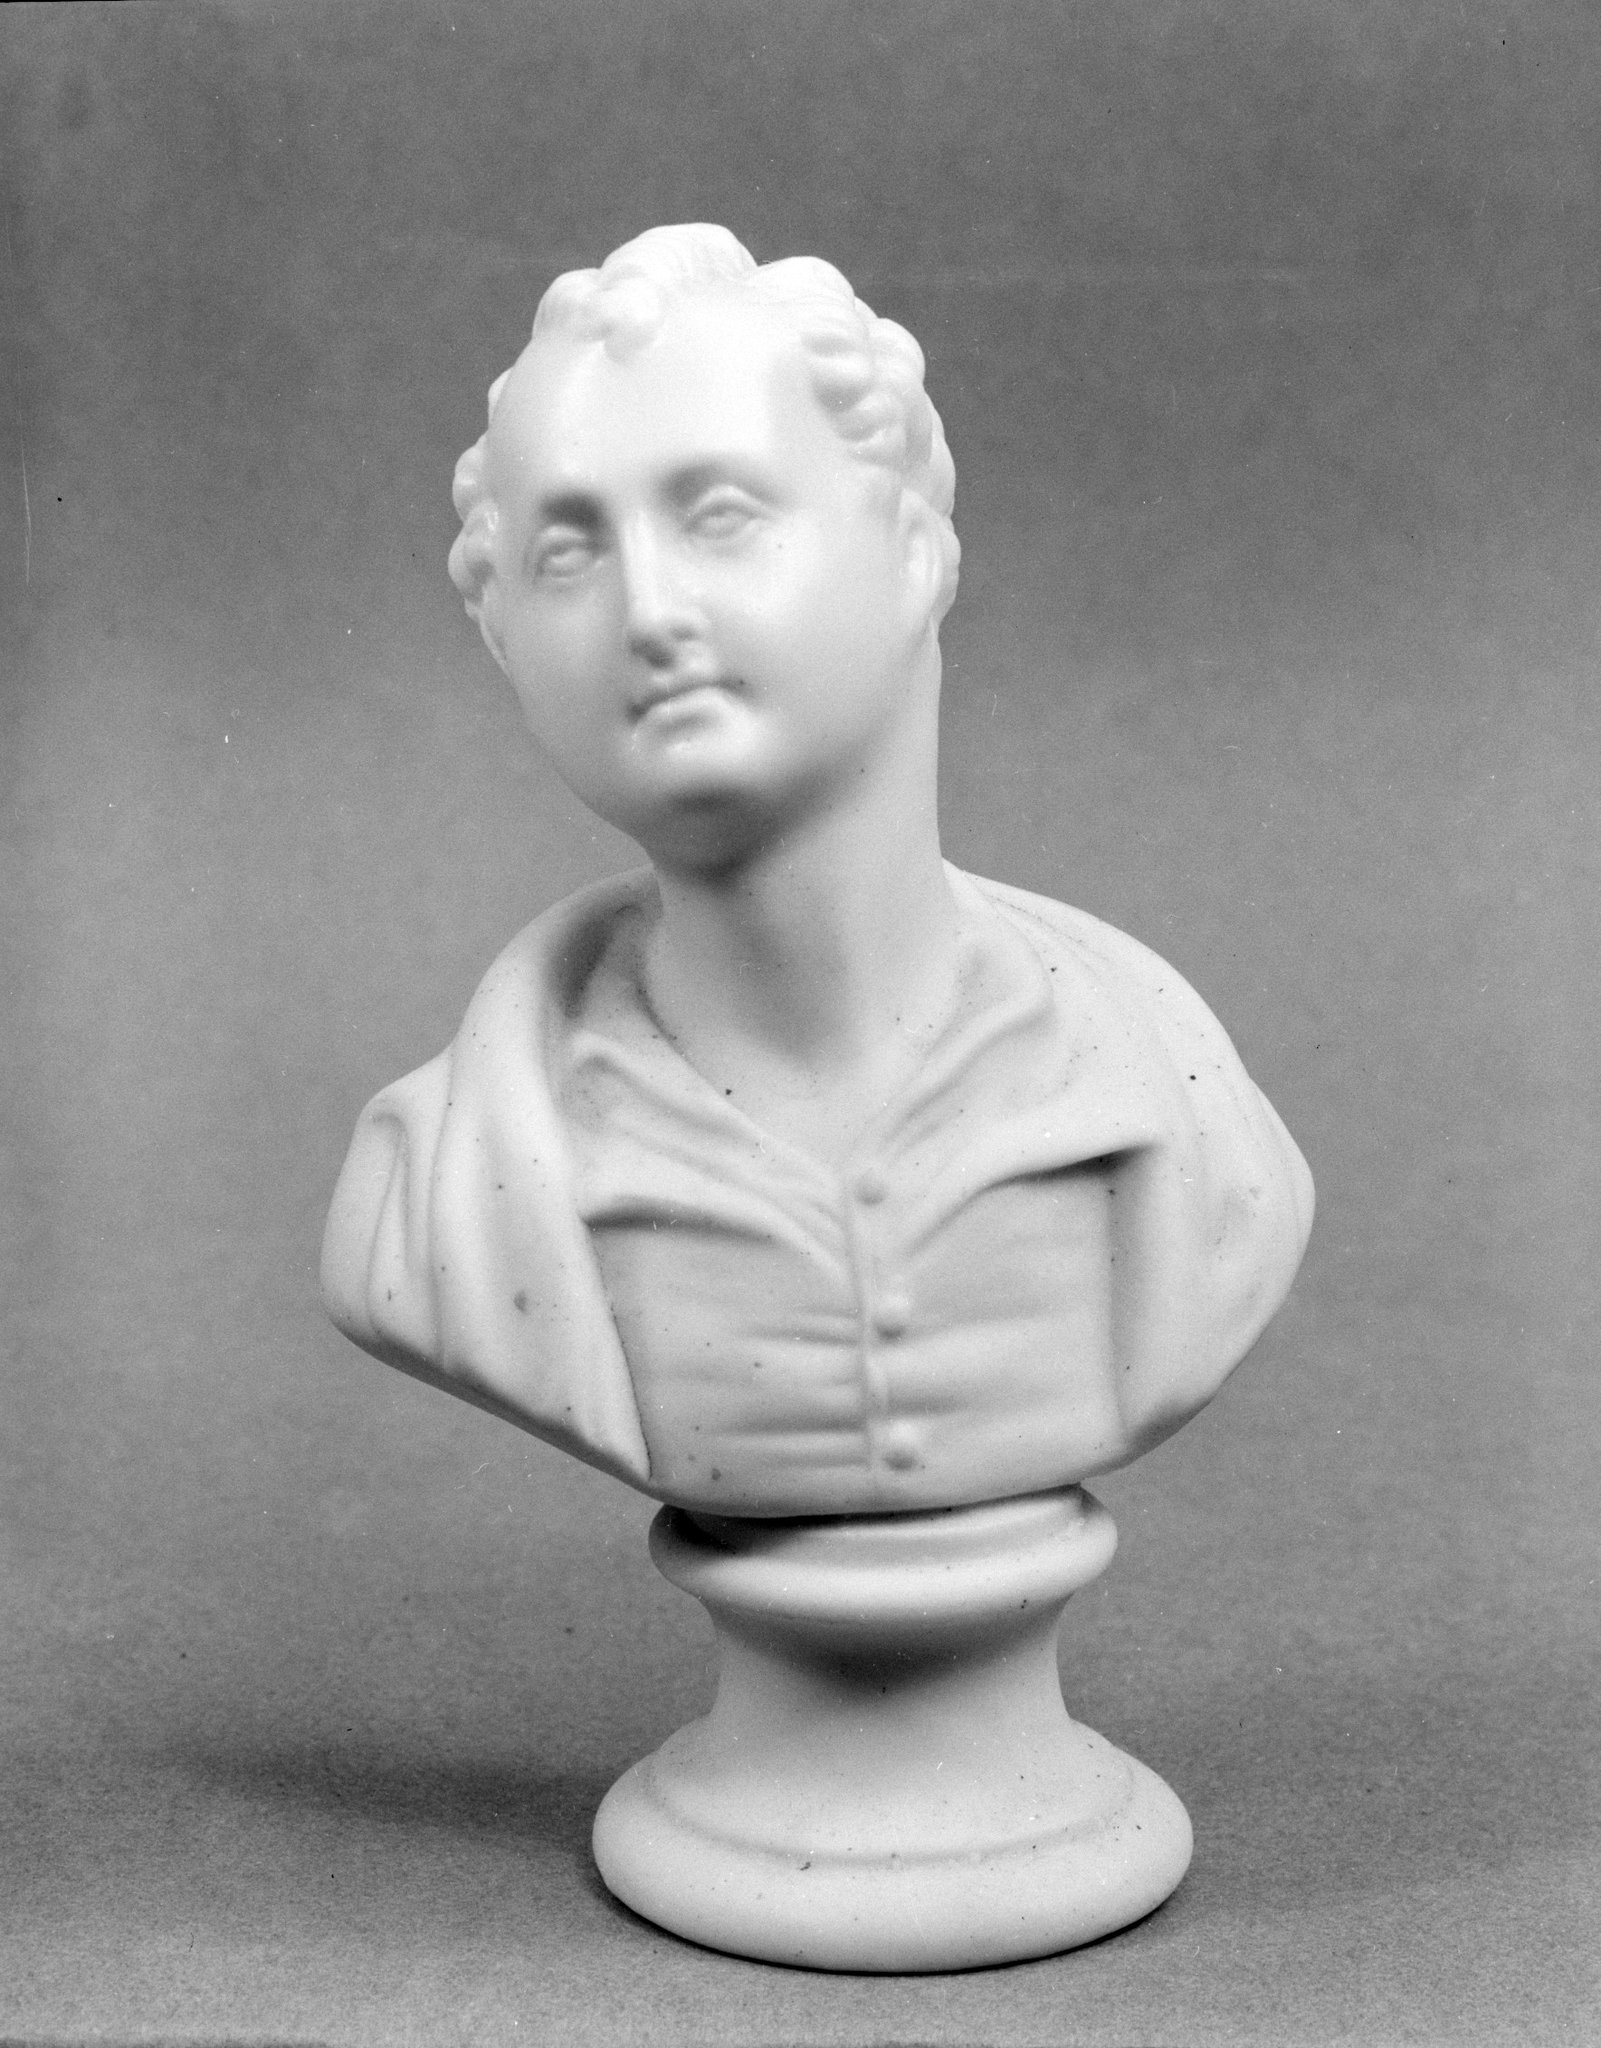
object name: bust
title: Bust of Lord Byron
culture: american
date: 1830-1870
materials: porcelain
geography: united states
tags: men,portraits